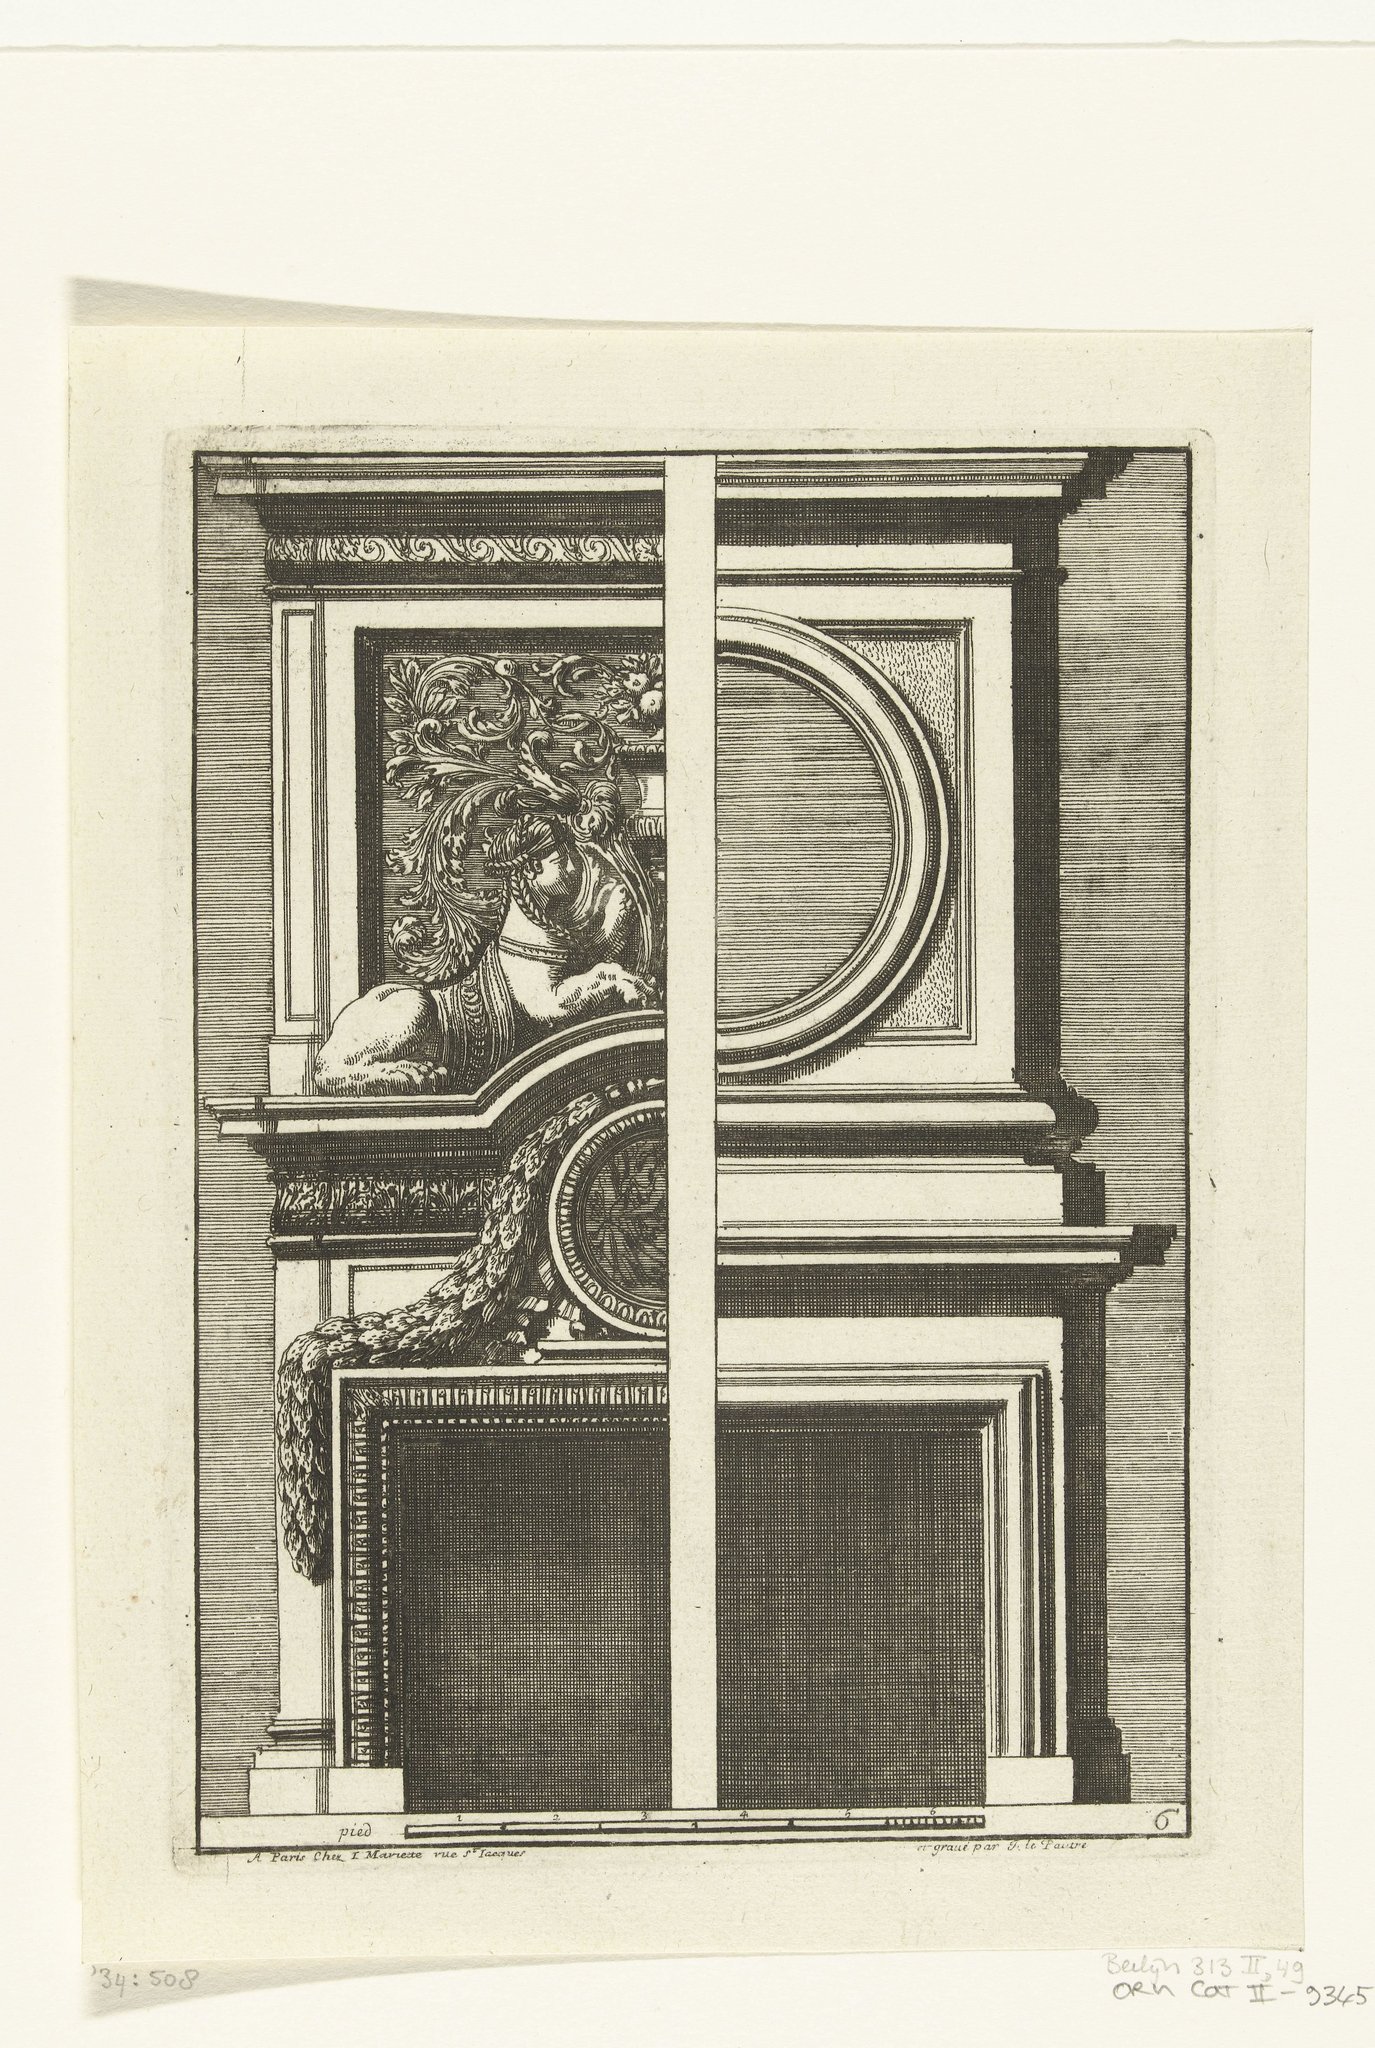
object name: print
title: Onderboezem met variant voor rechterhelft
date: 1710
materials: paper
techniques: etching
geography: paris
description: Linksboven ligt een sfinx naast een bladrank en een vaas. Uit tweede editie.